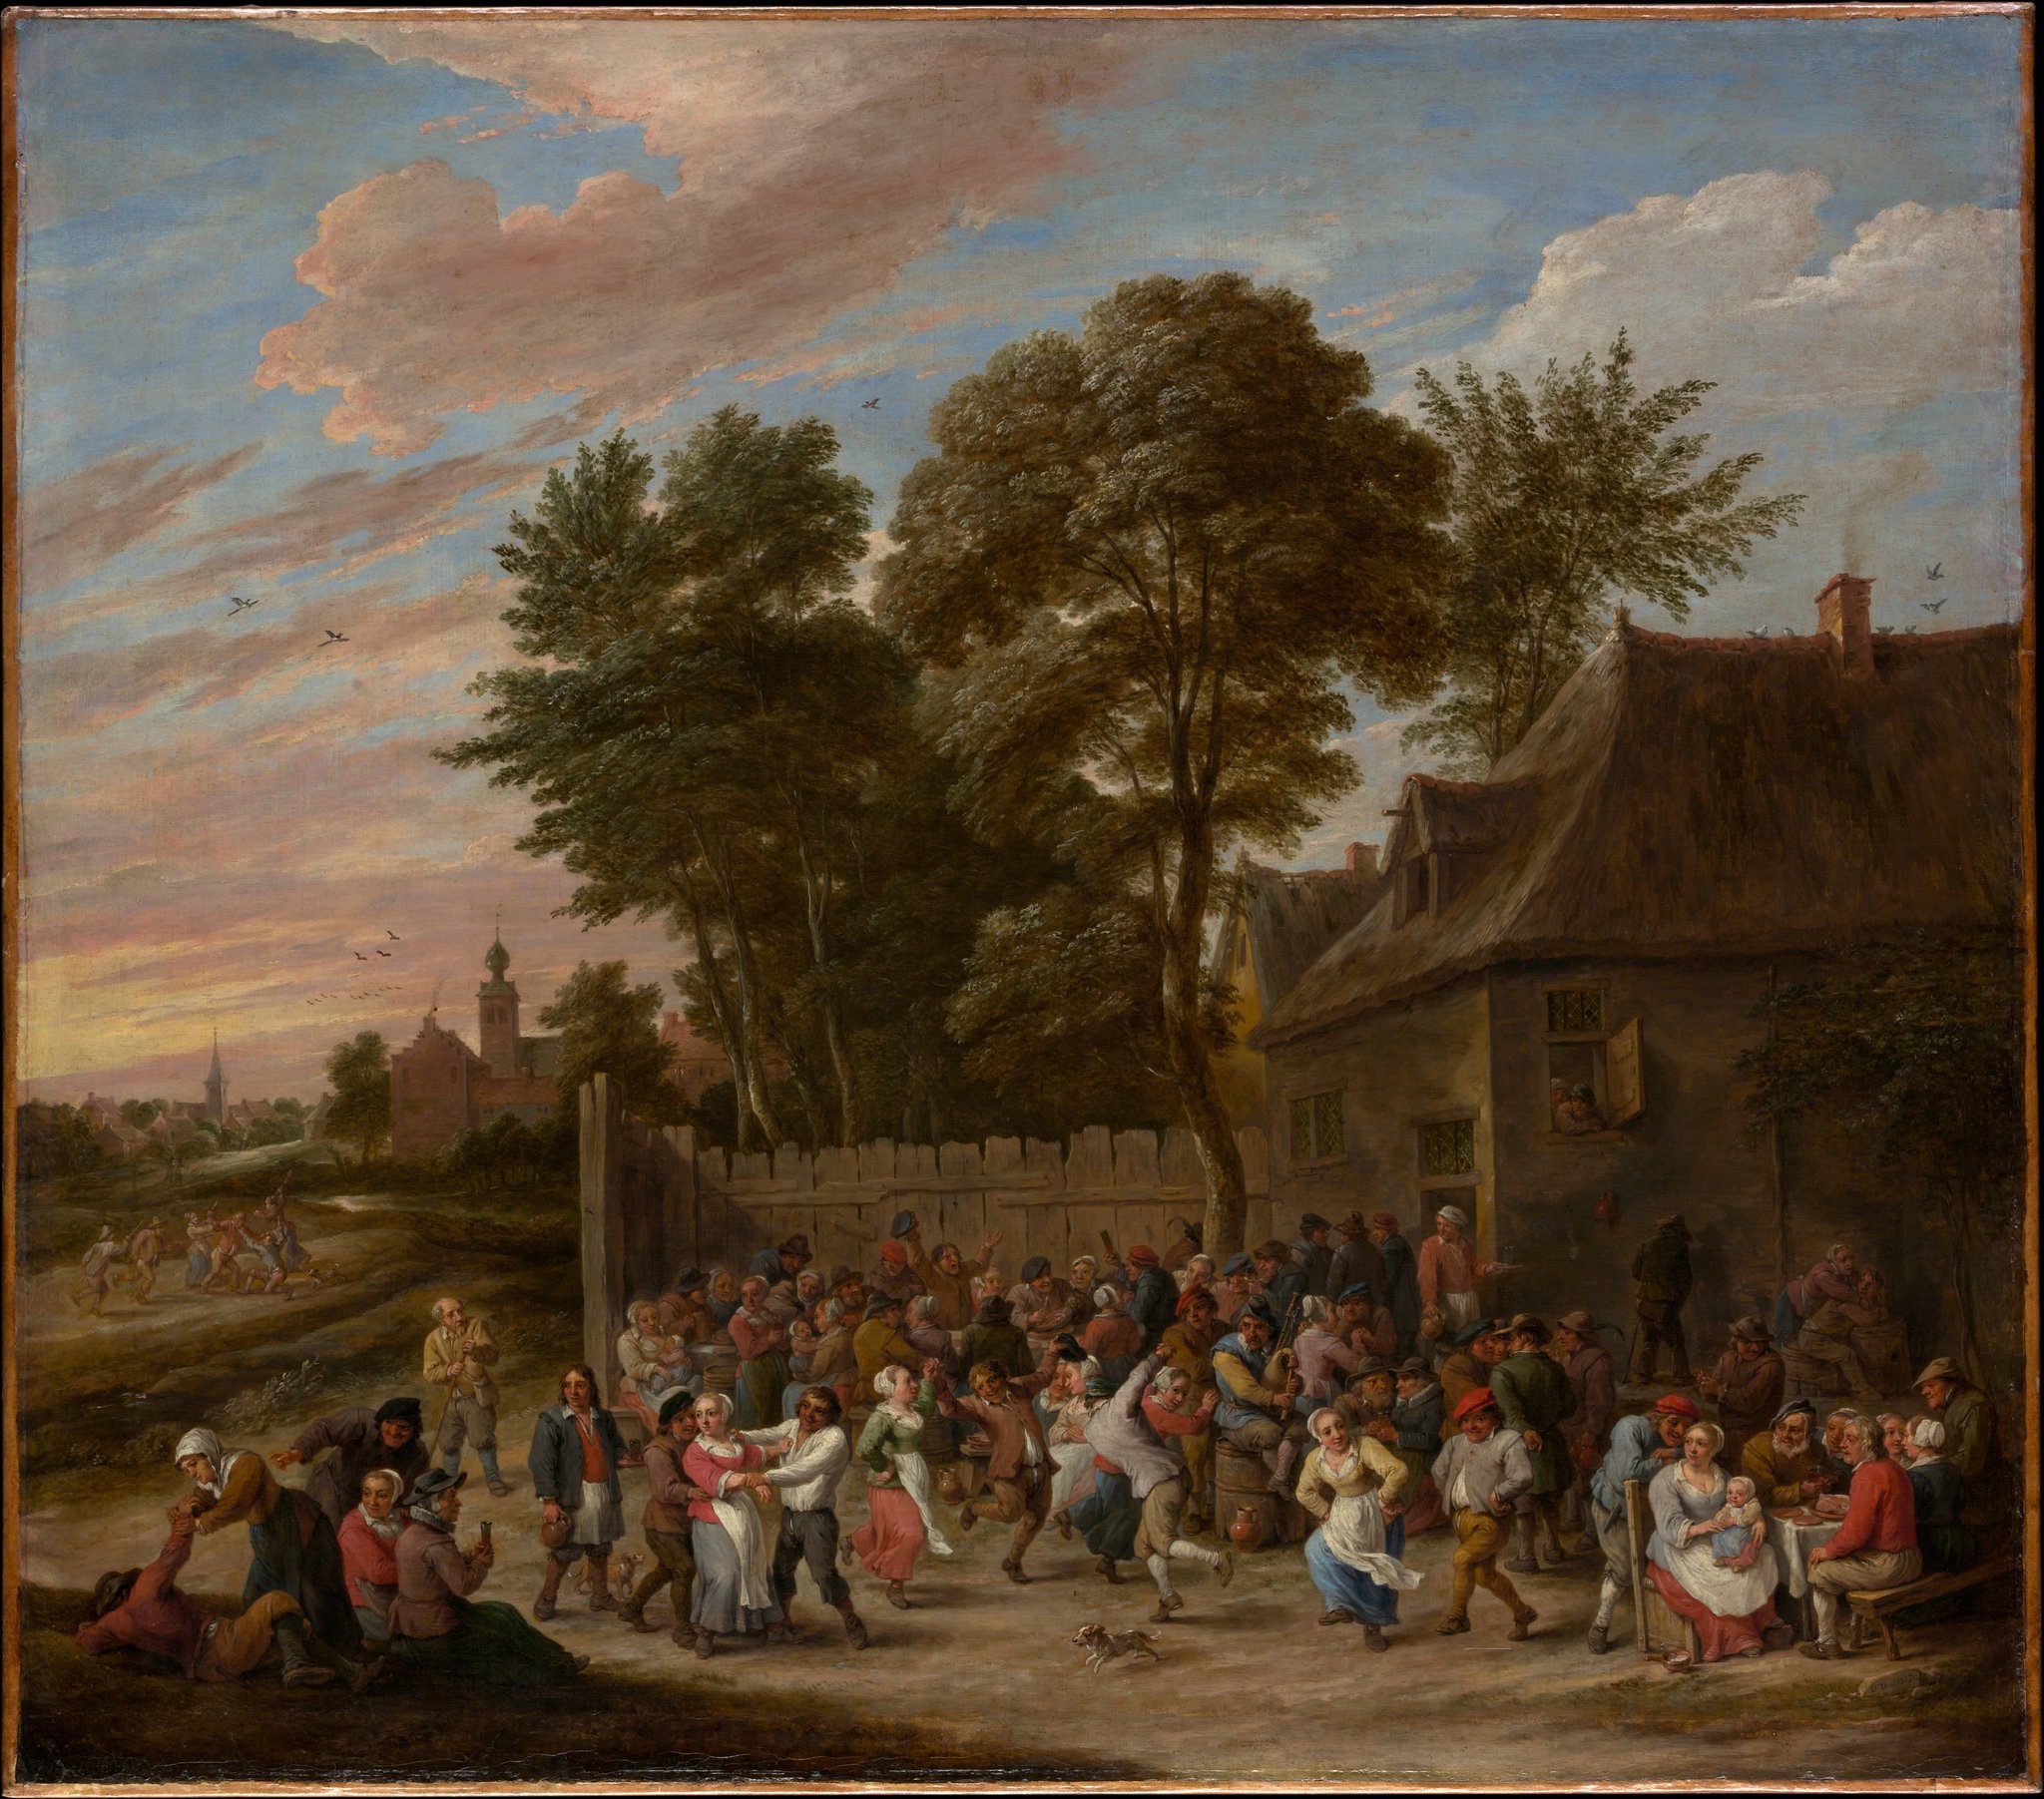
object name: painting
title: Peasants Dancing and Feasting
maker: david teniers the younger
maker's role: artist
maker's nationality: flemish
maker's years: 1610-1690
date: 1660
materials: canvas, oil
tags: men,women,dancing,eating